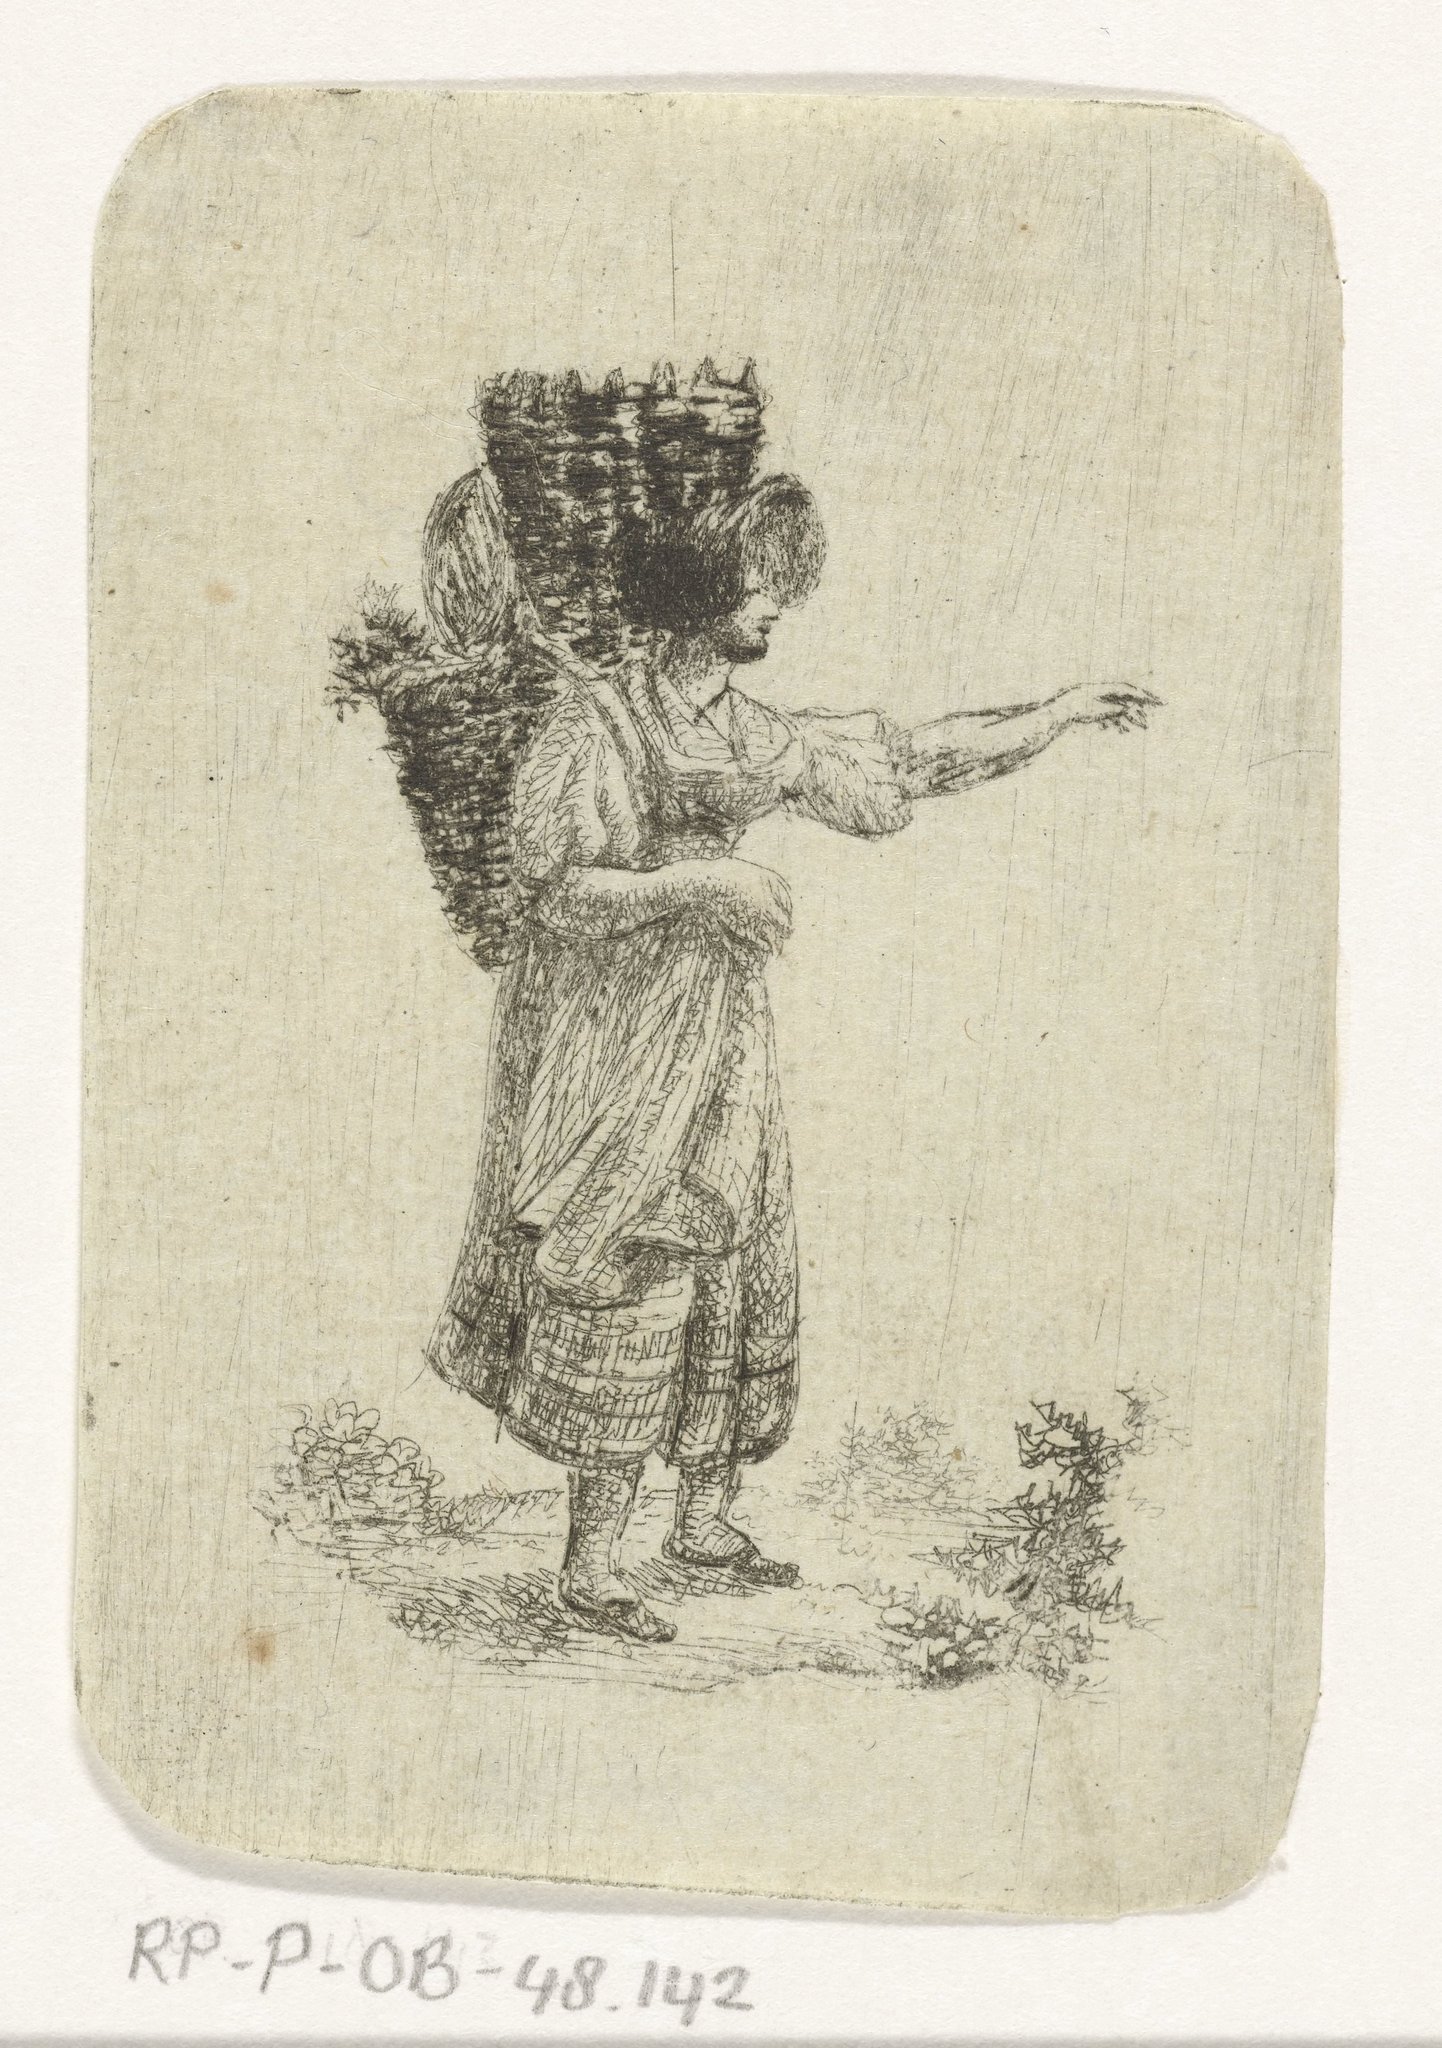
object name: print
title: Vrouw met manden op de rug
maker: otto baron howen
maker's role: draughtsman, print maker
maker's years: 1774-1848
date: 1784-1848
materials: paper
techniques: etching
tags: adult woman (+ front view)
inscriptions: collector's mark: Lugt 2228